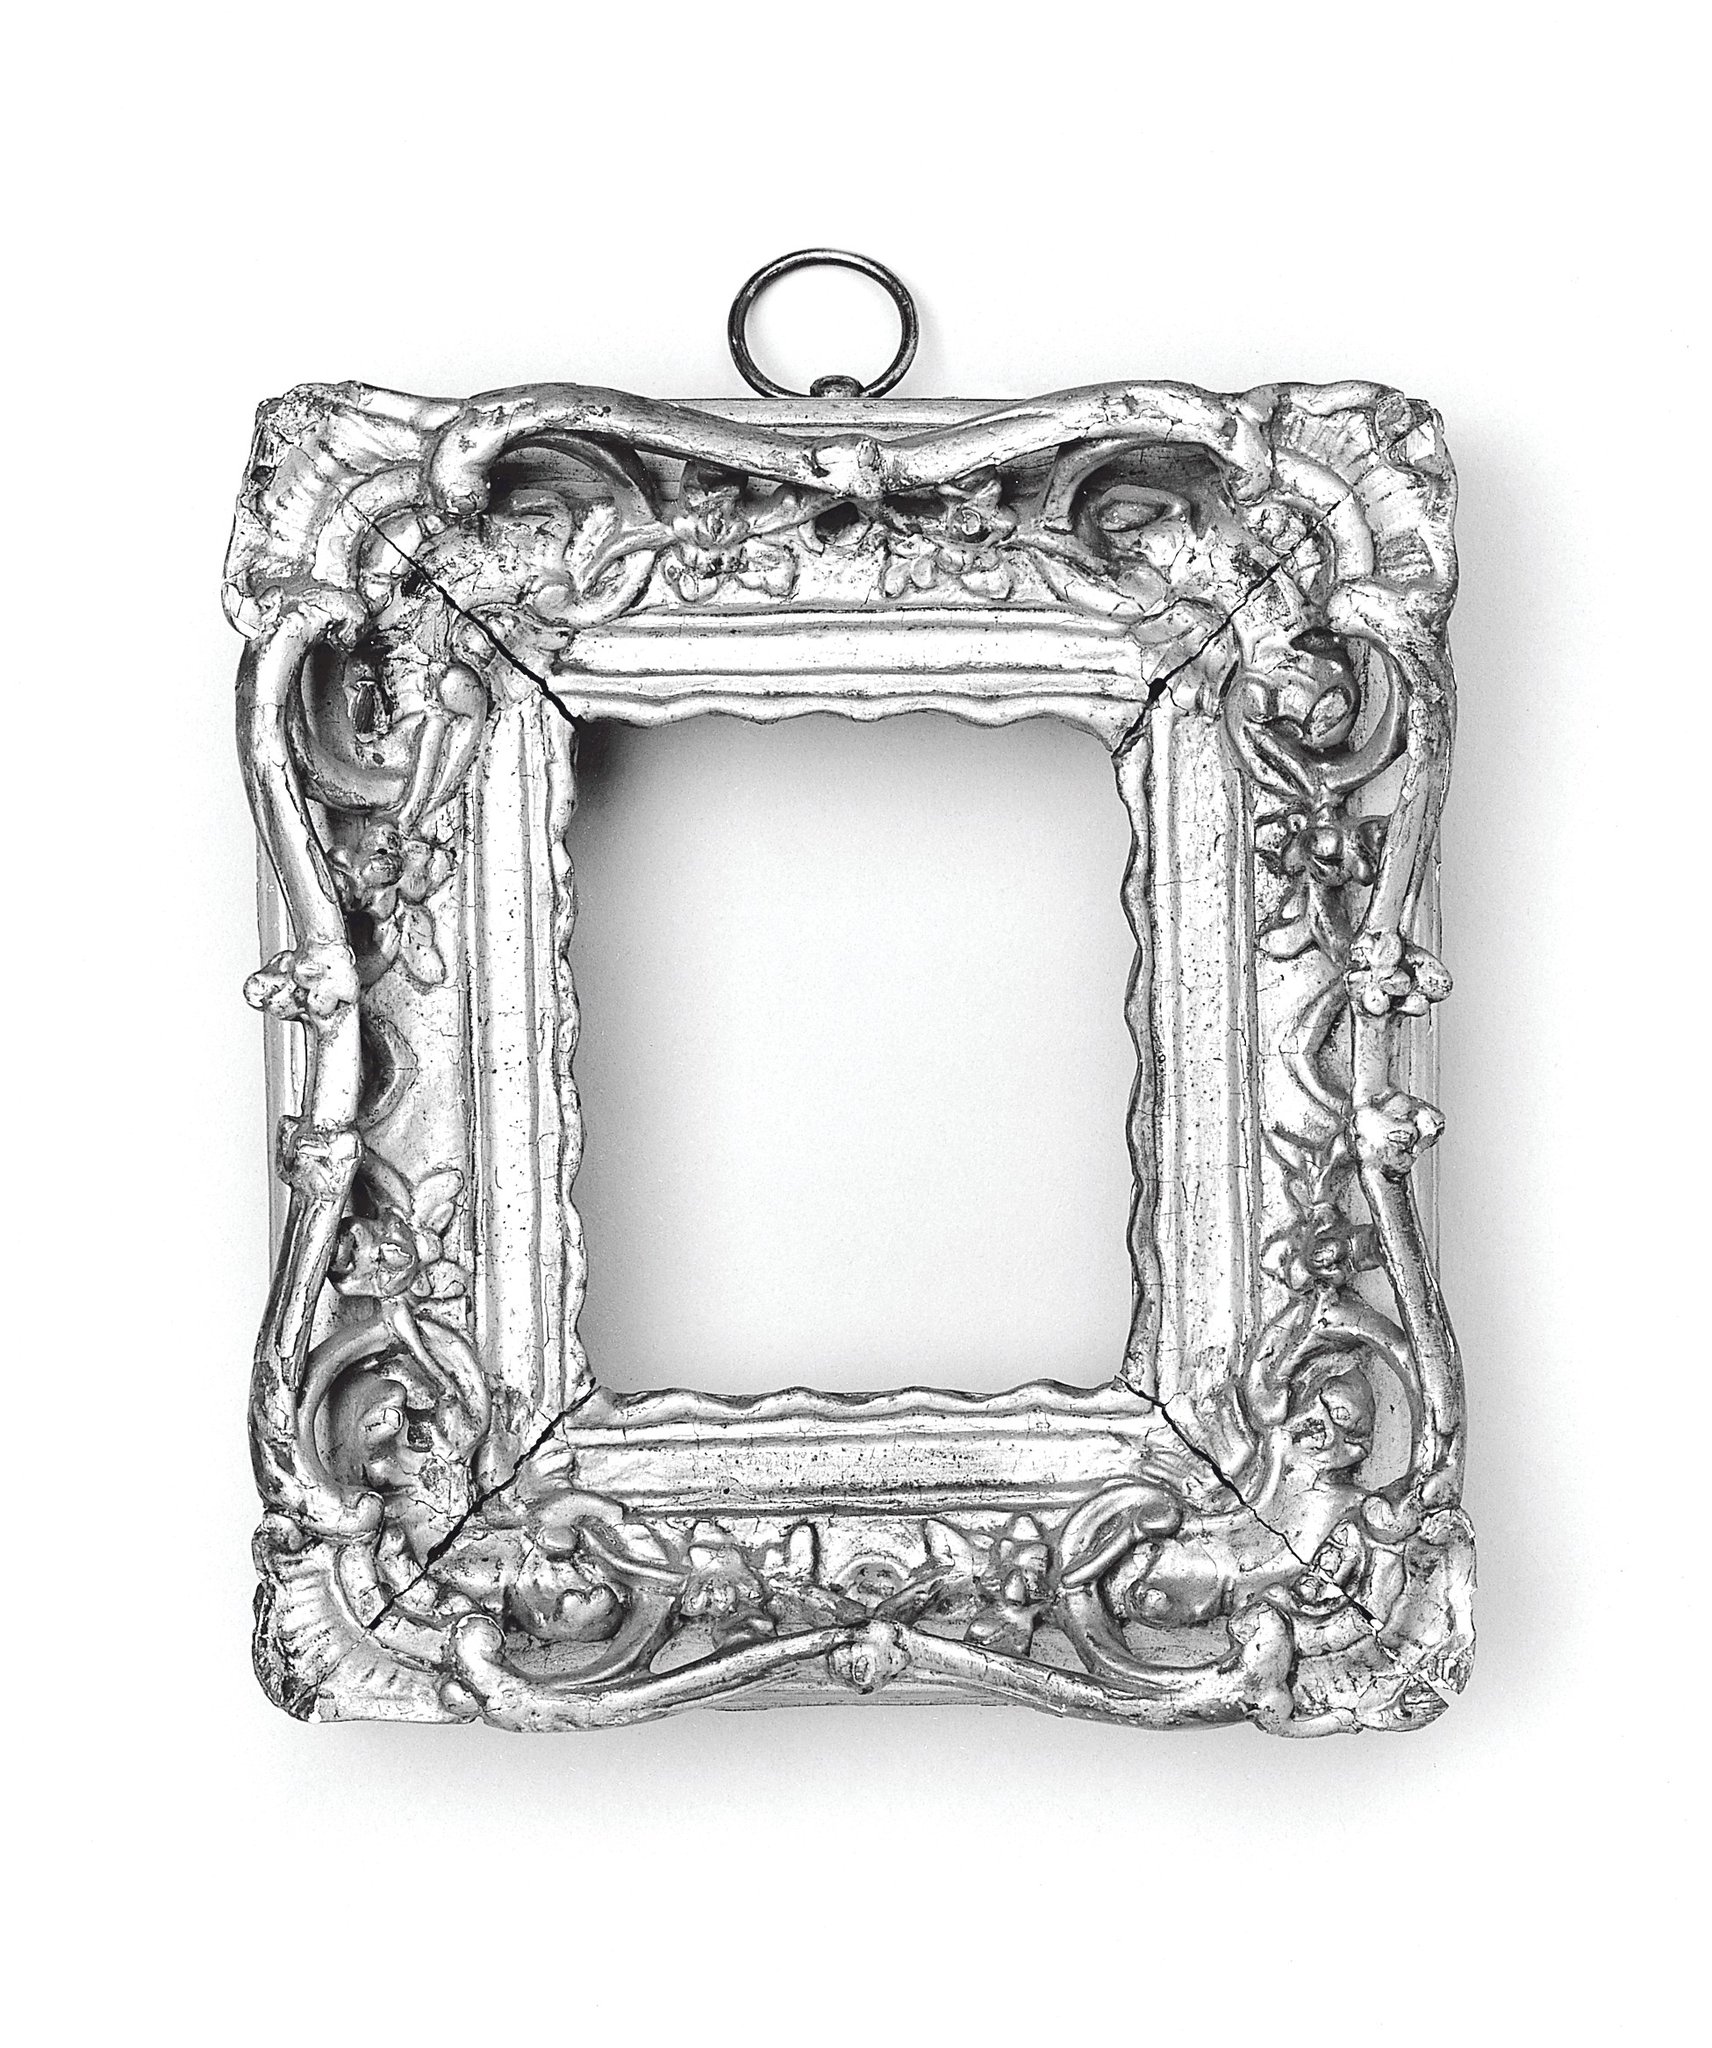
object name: frame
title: Swept frame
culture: eastern european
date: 1740-1749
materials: feather, wood